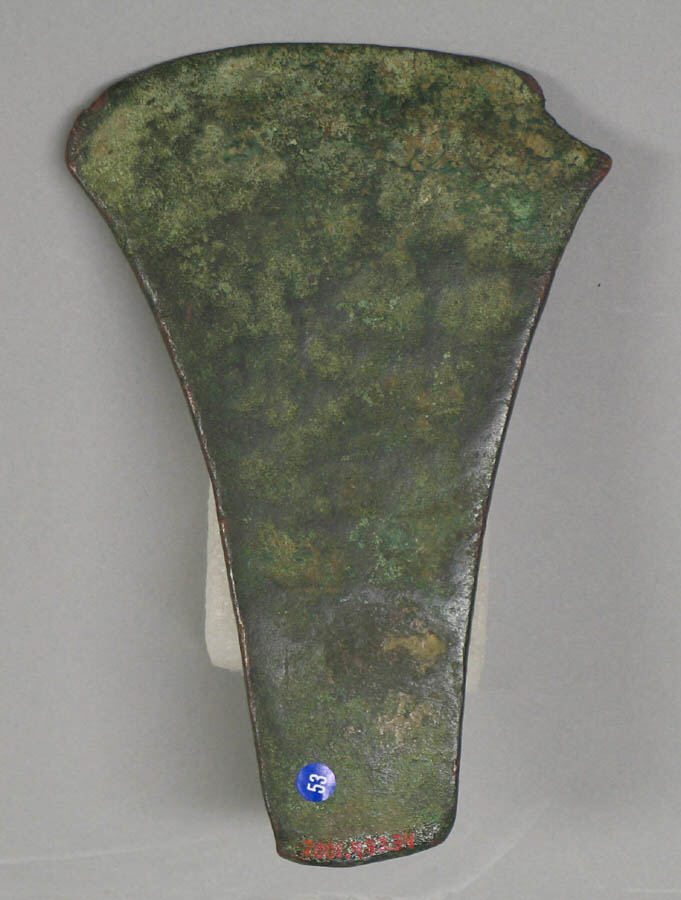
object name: ax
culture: indian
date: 1500-500 BCE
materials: copper